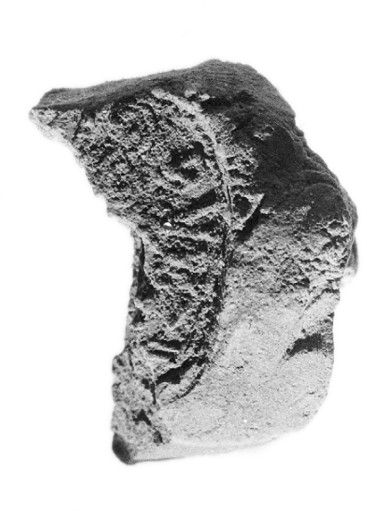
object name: sealing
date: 1981-1640 BCE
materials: mud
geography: egypt